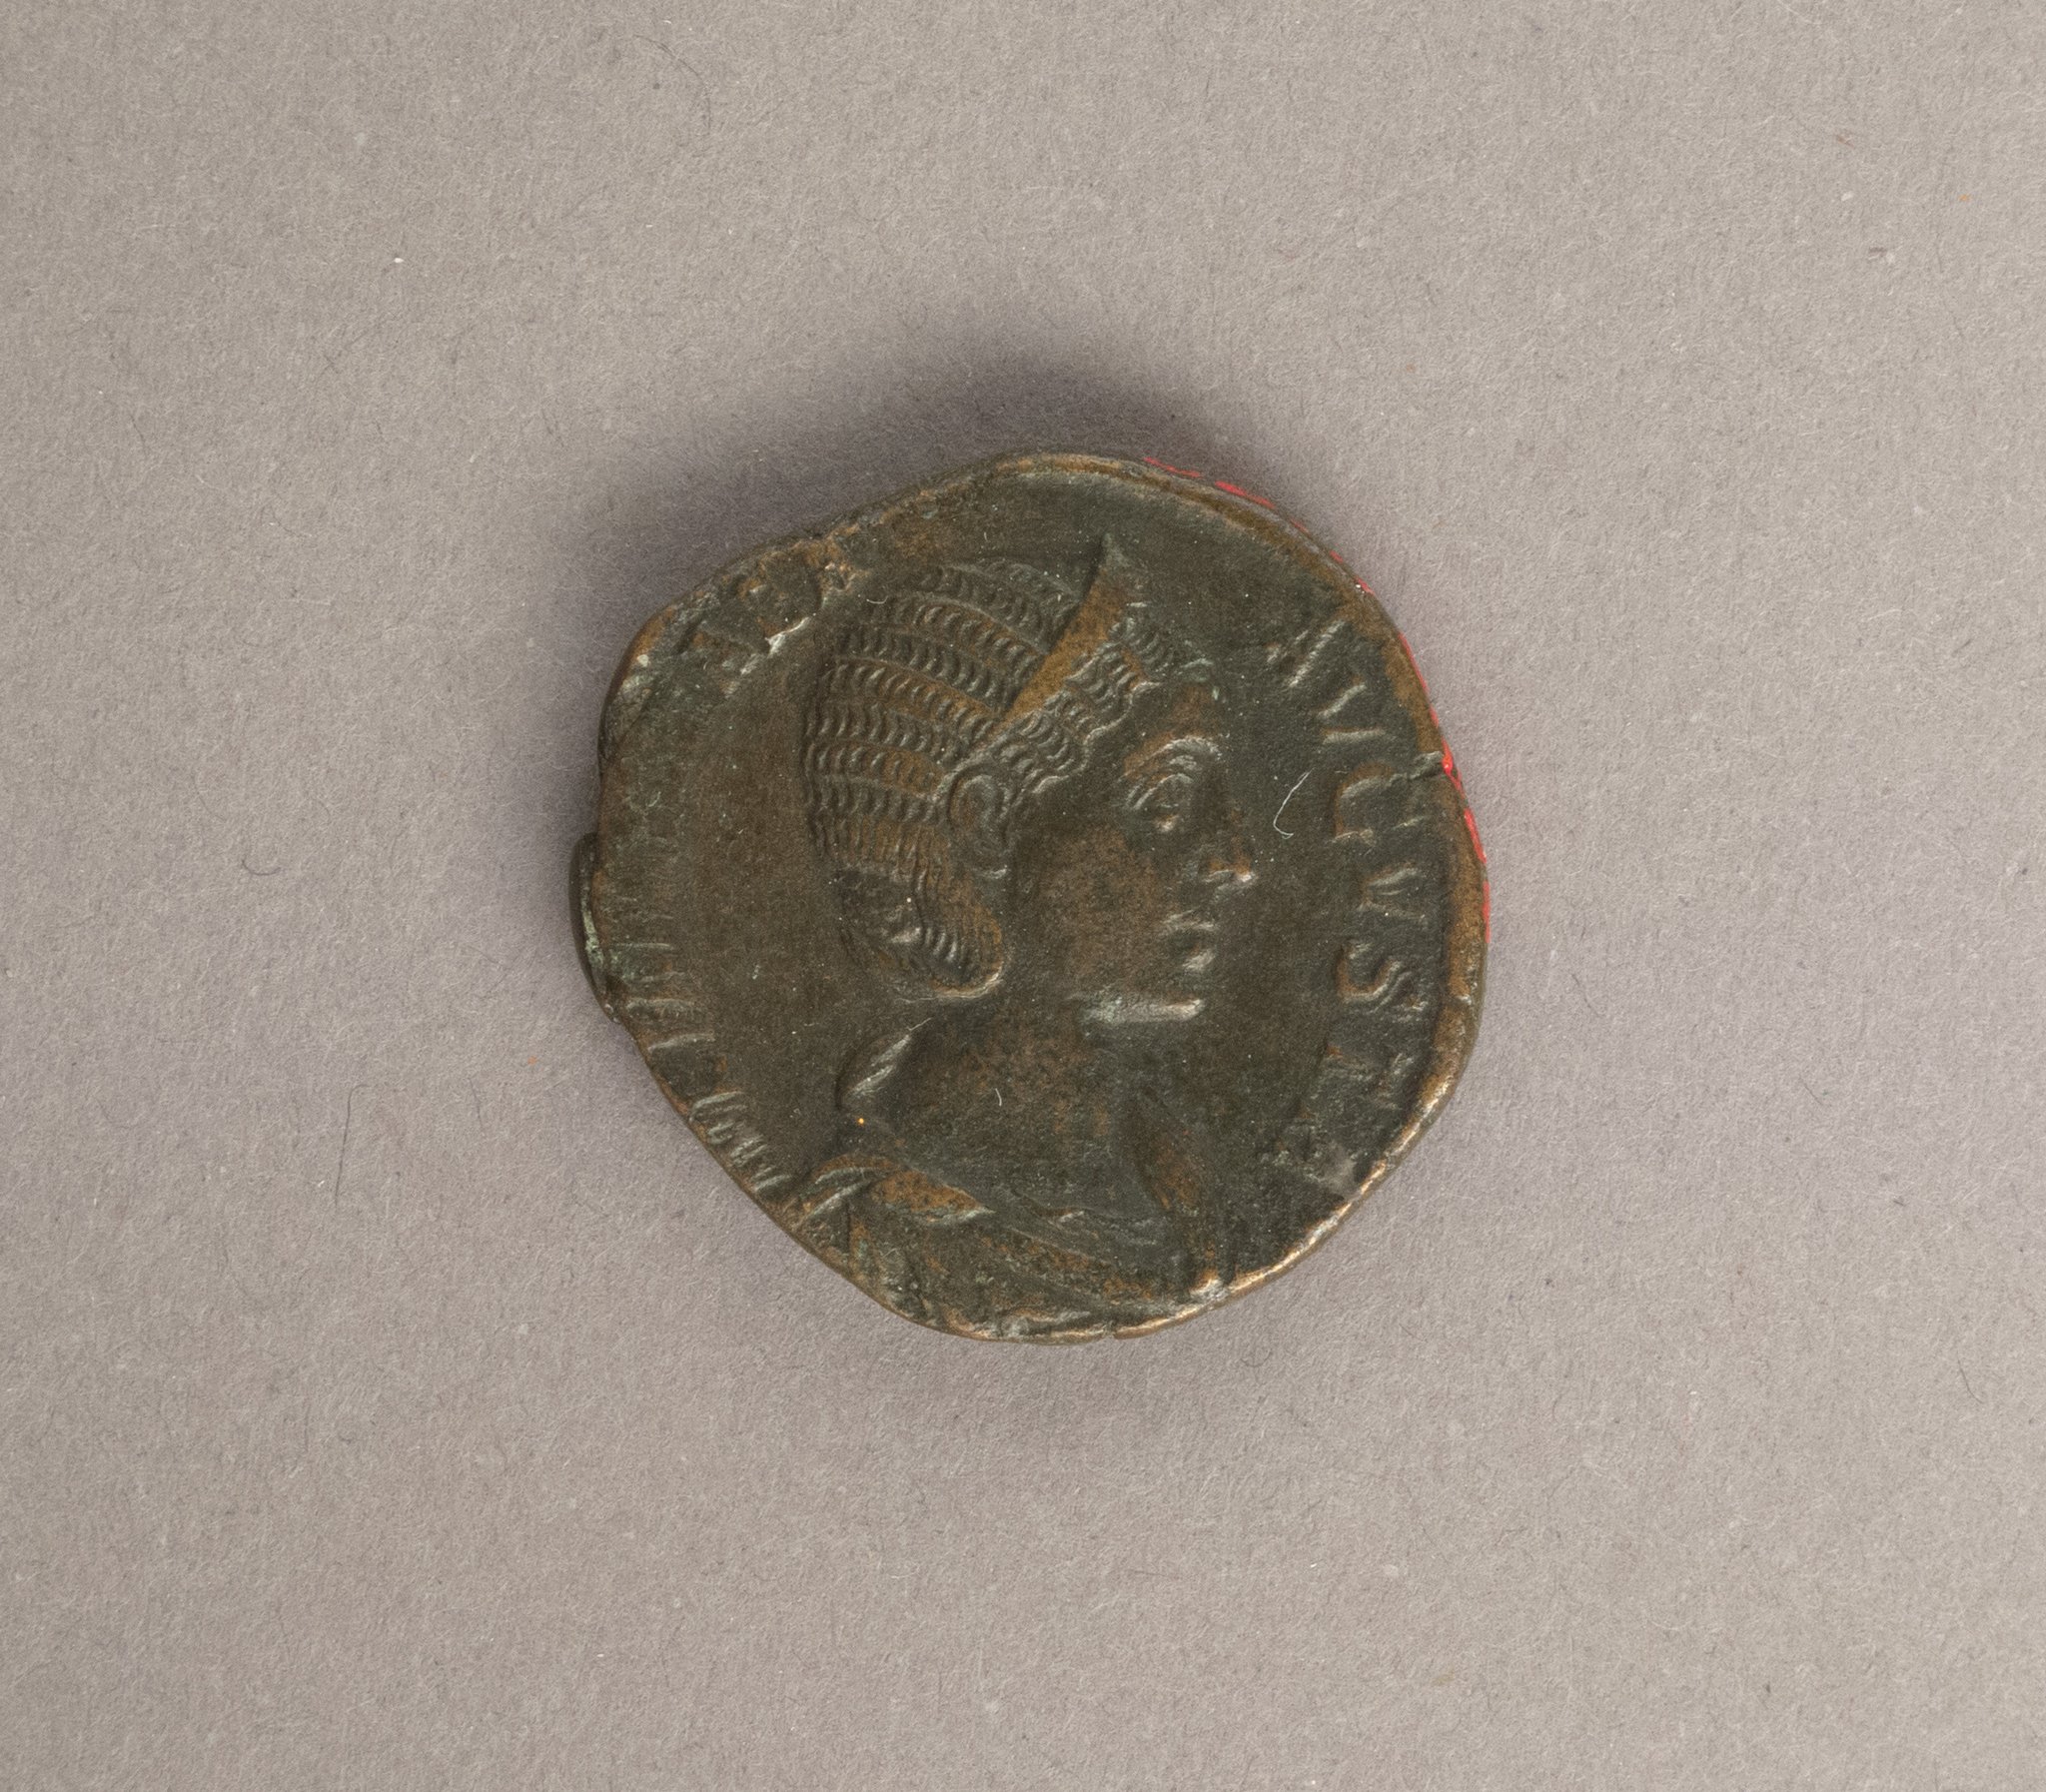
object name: sestertius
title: Orichalcum sestertius of Alexander Severus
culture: roman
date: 222-235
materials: bronze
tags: men,profiles